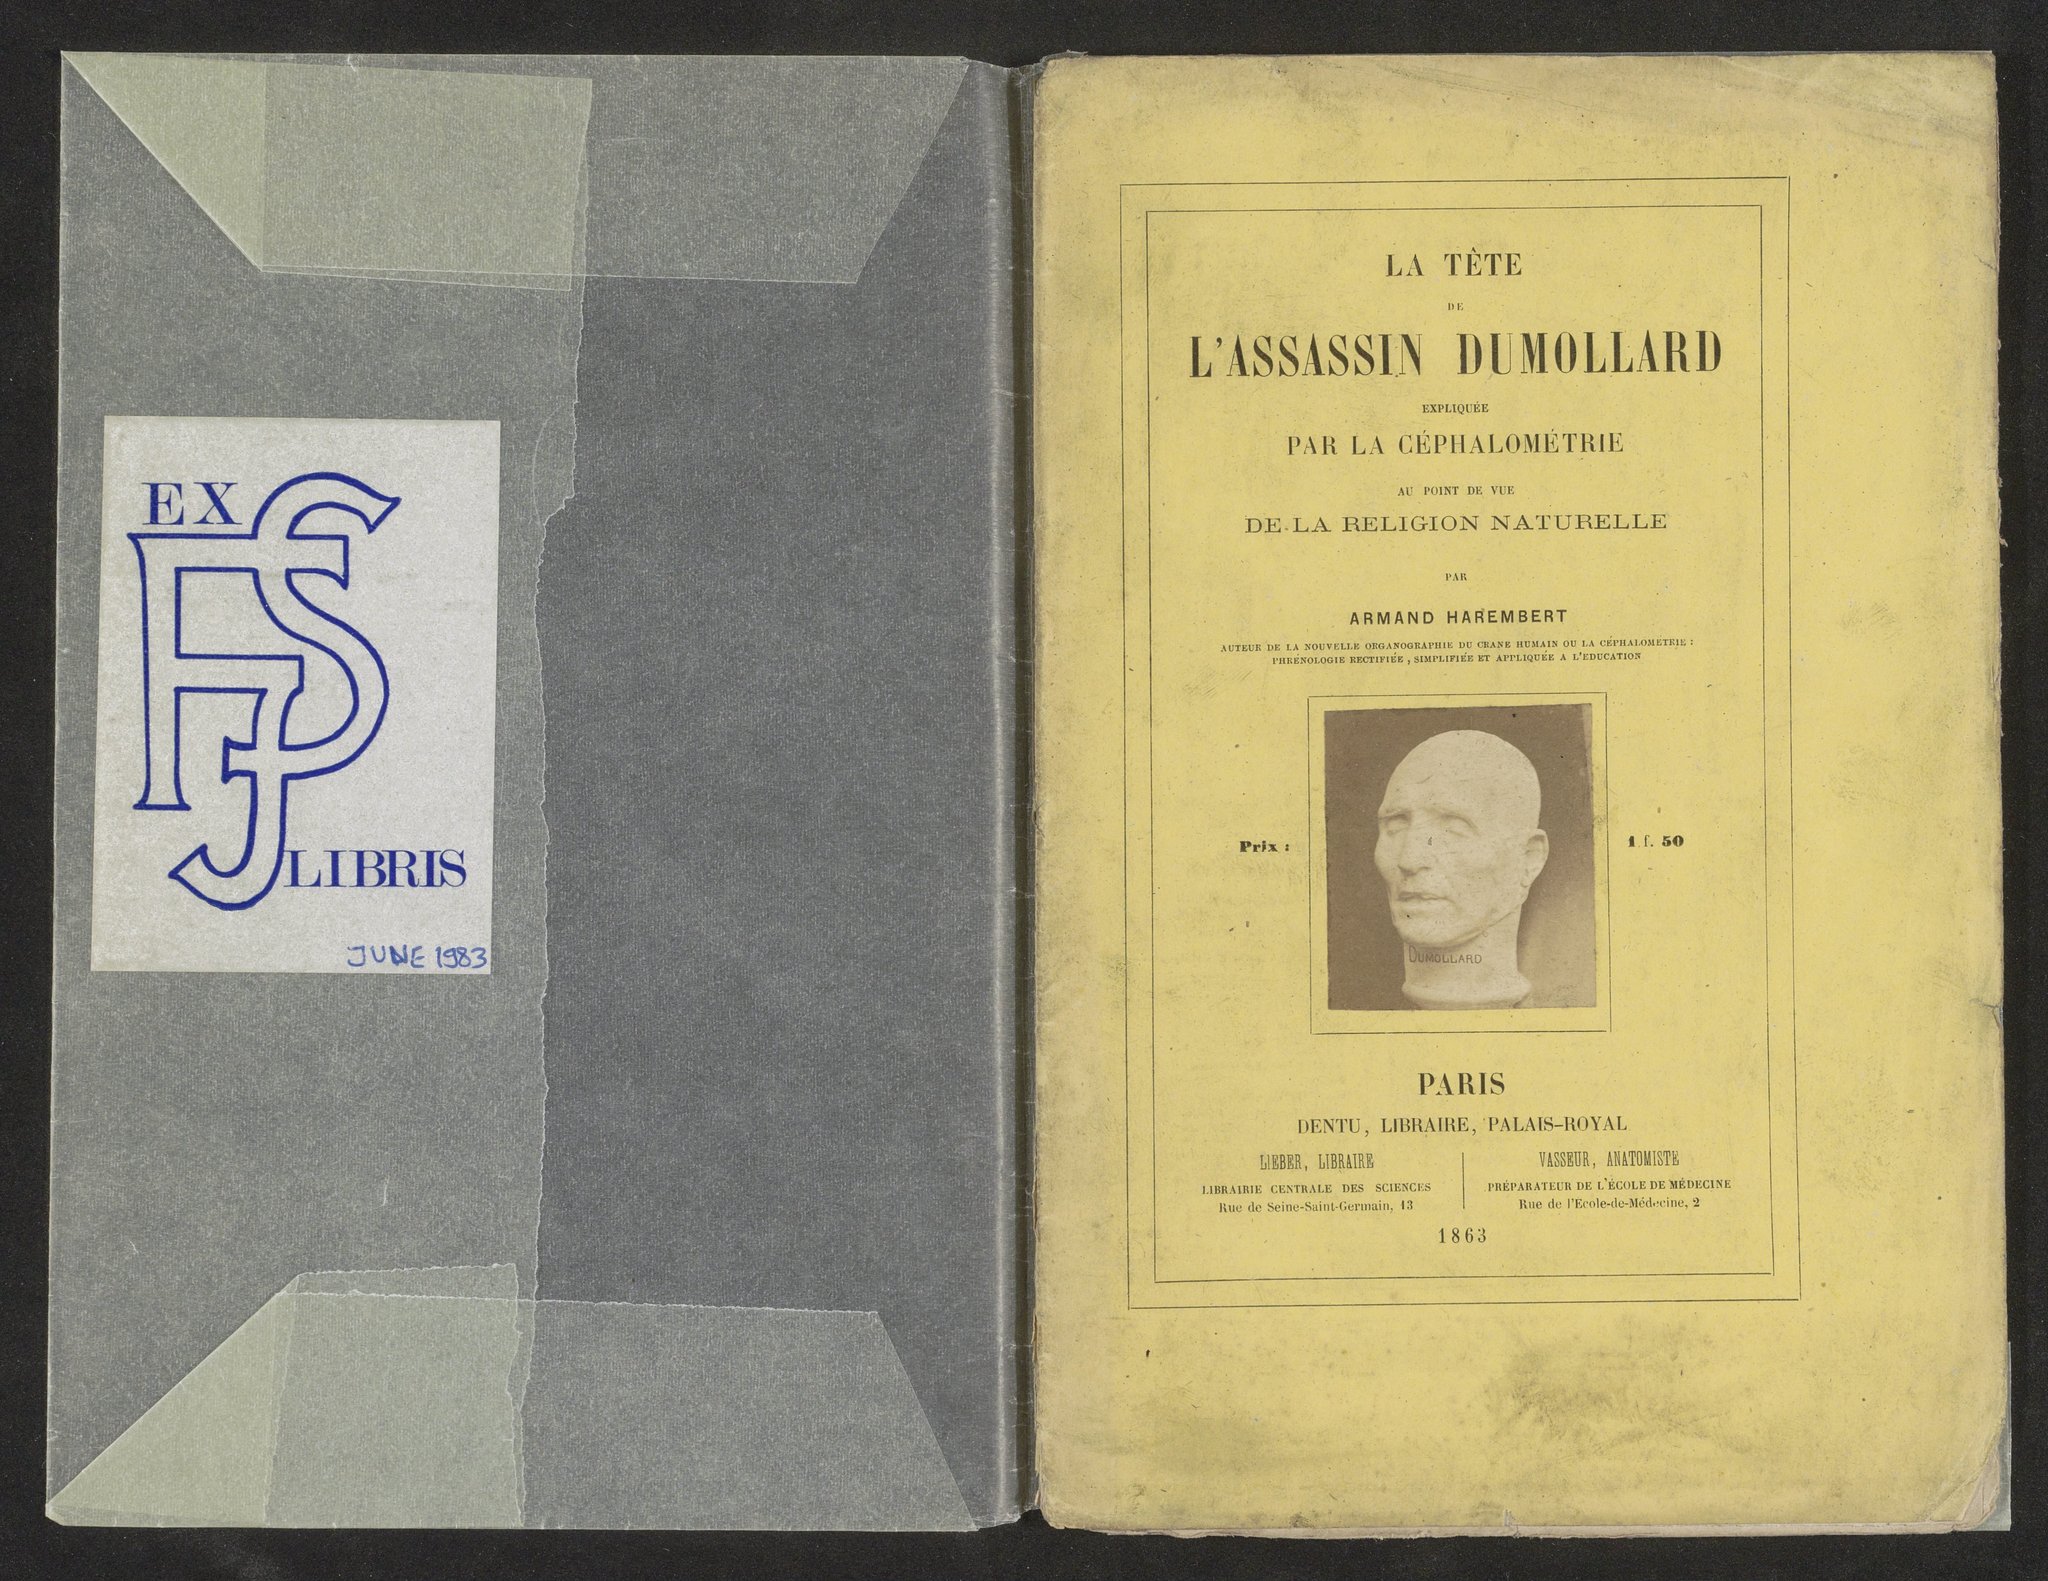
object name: photograph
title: Gipsmodel van het hoofd van seriemoordenaar Martin Dumollard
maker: Anonymous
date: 1862-1863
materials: photographic support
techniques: albumen print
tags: head of a beheaded person